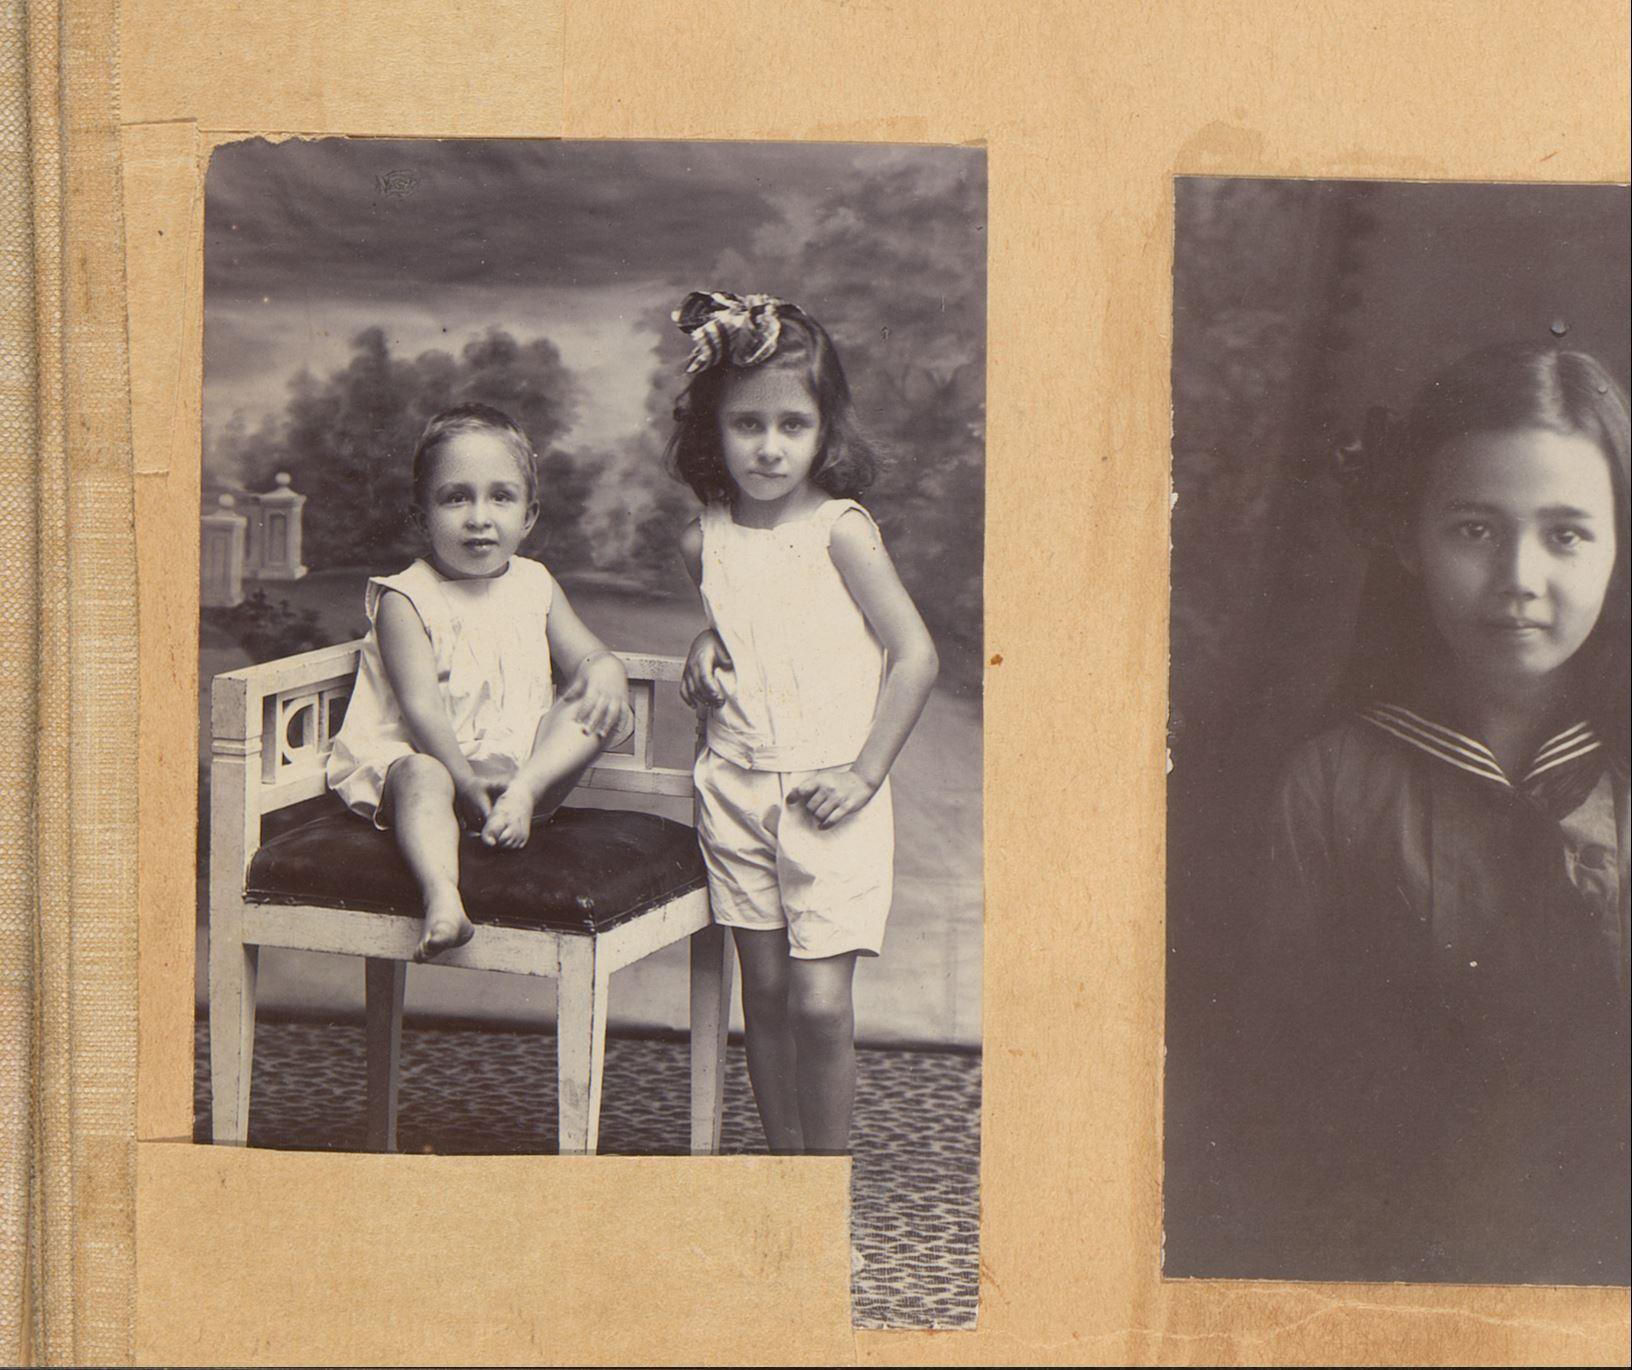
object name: photograph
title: Portret van twee jonge kinderen, vermoedelijk in Nederlands-Indië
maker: Anonymous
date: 1917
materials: photographic support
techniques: gelatin silver print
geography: dutch east indies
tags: child, dutch east indies, the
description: Onderdeel van Familiealbum met foto's van een familie in de voormalige kolonie Nederlands-Indië en van een suikerfabriek in Purworejo.